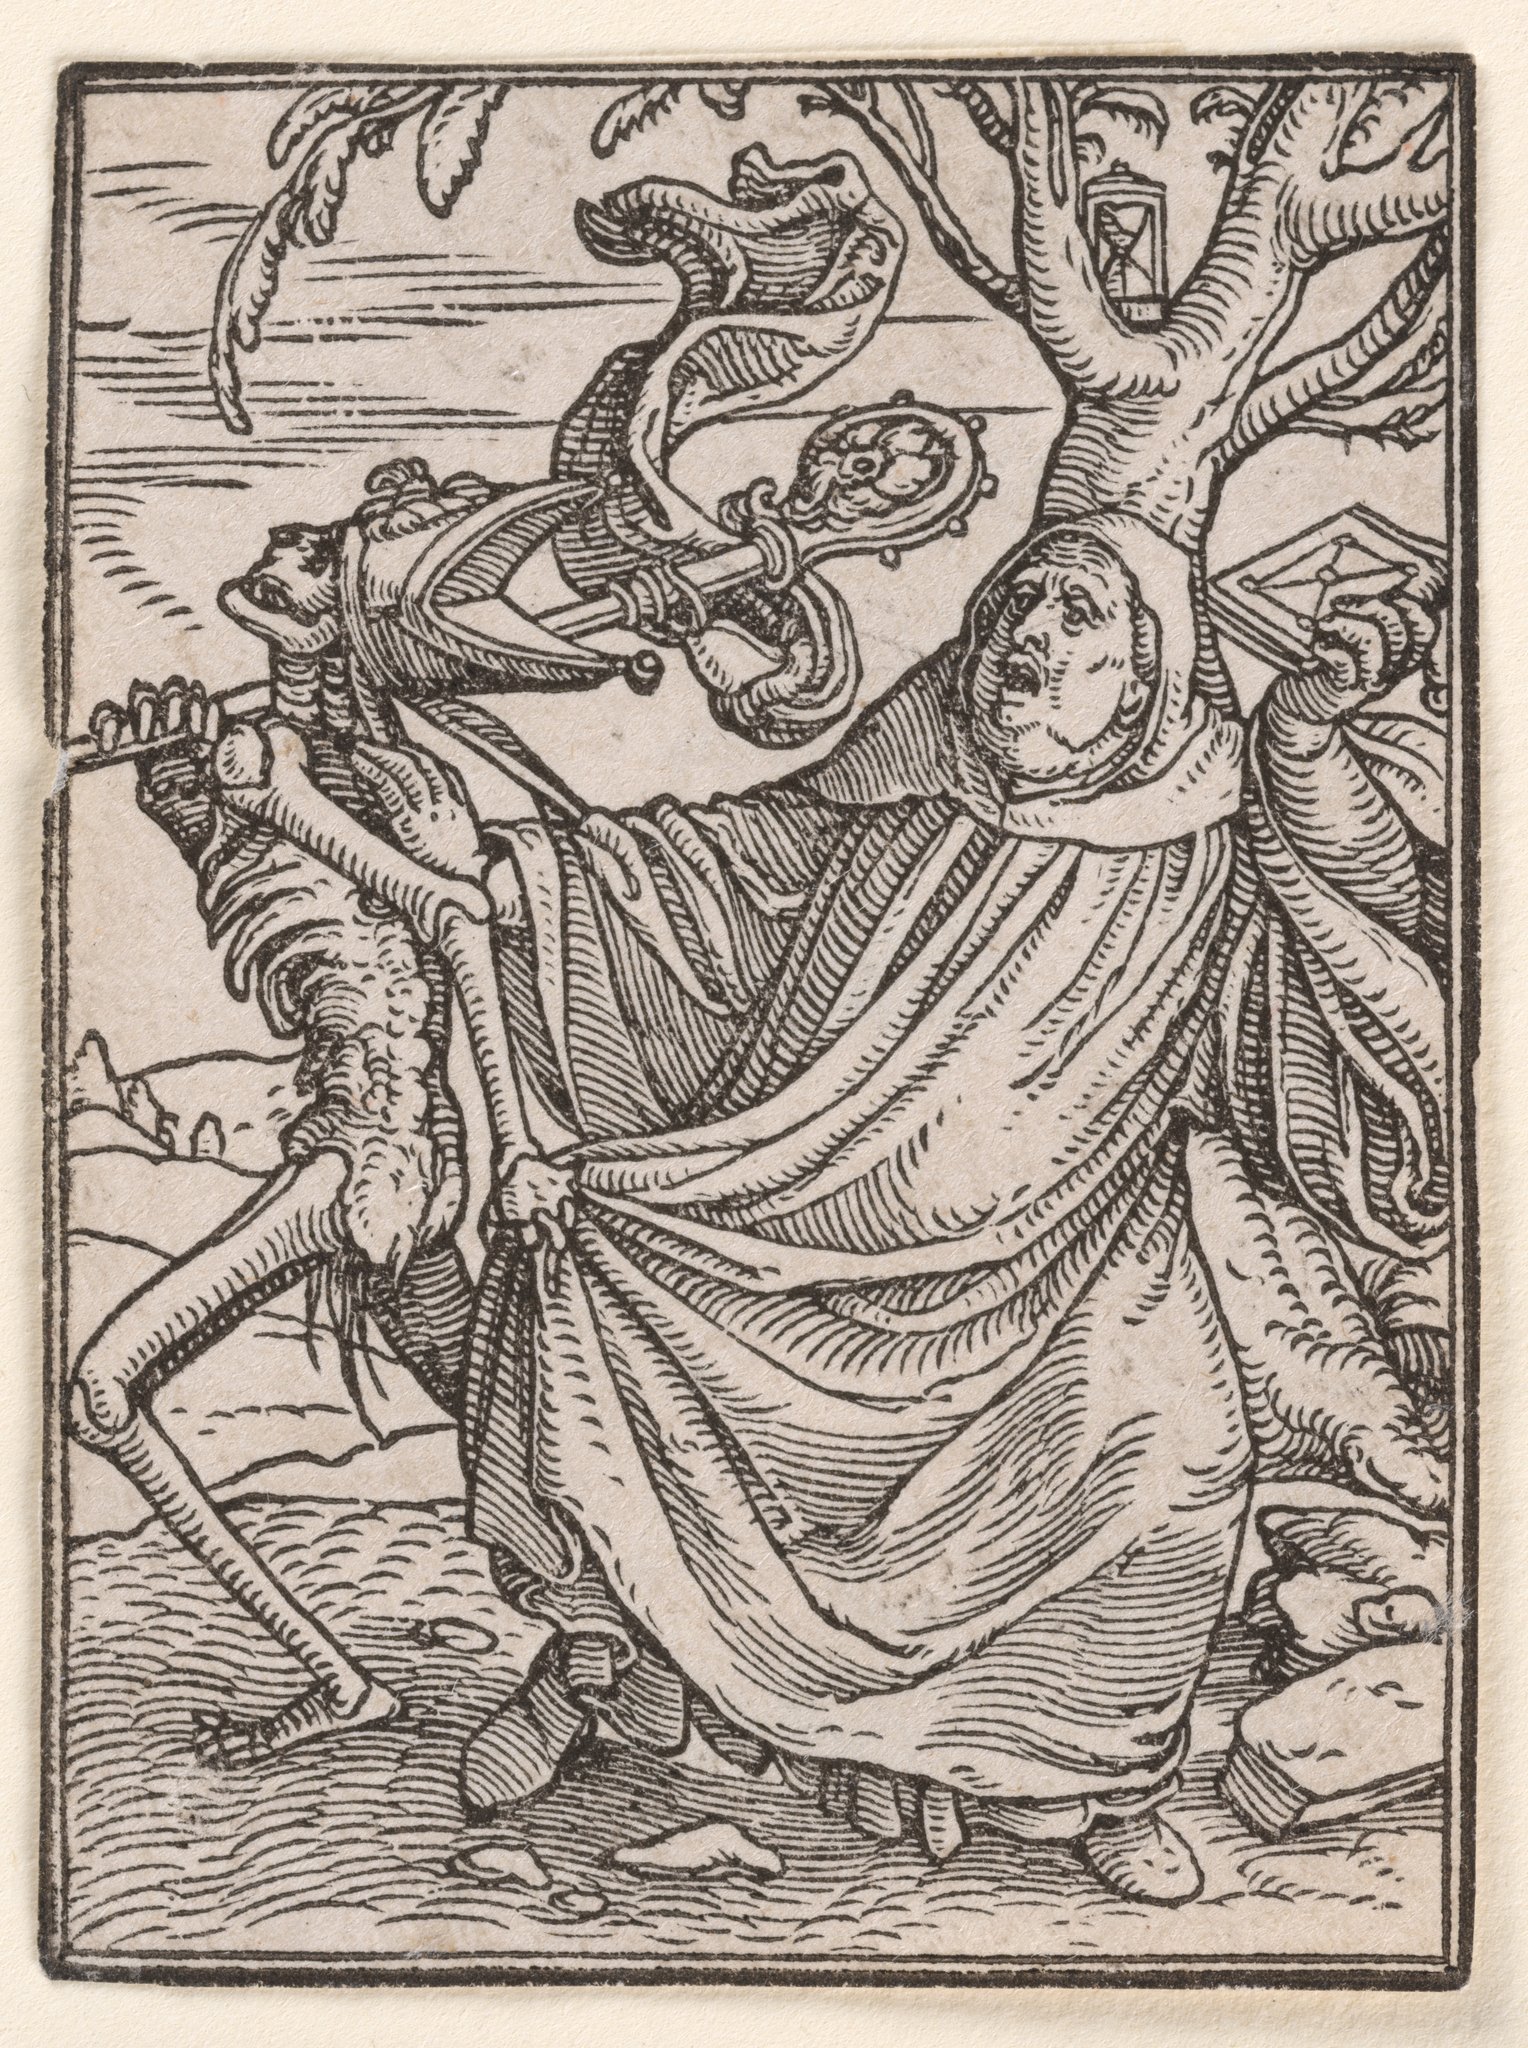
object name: print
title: The Abbot, from "The Dance of Death"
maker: hans holbein the younger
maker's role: artist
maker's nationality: german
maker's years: 1497-1543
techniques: woodcut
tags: skeletons,men